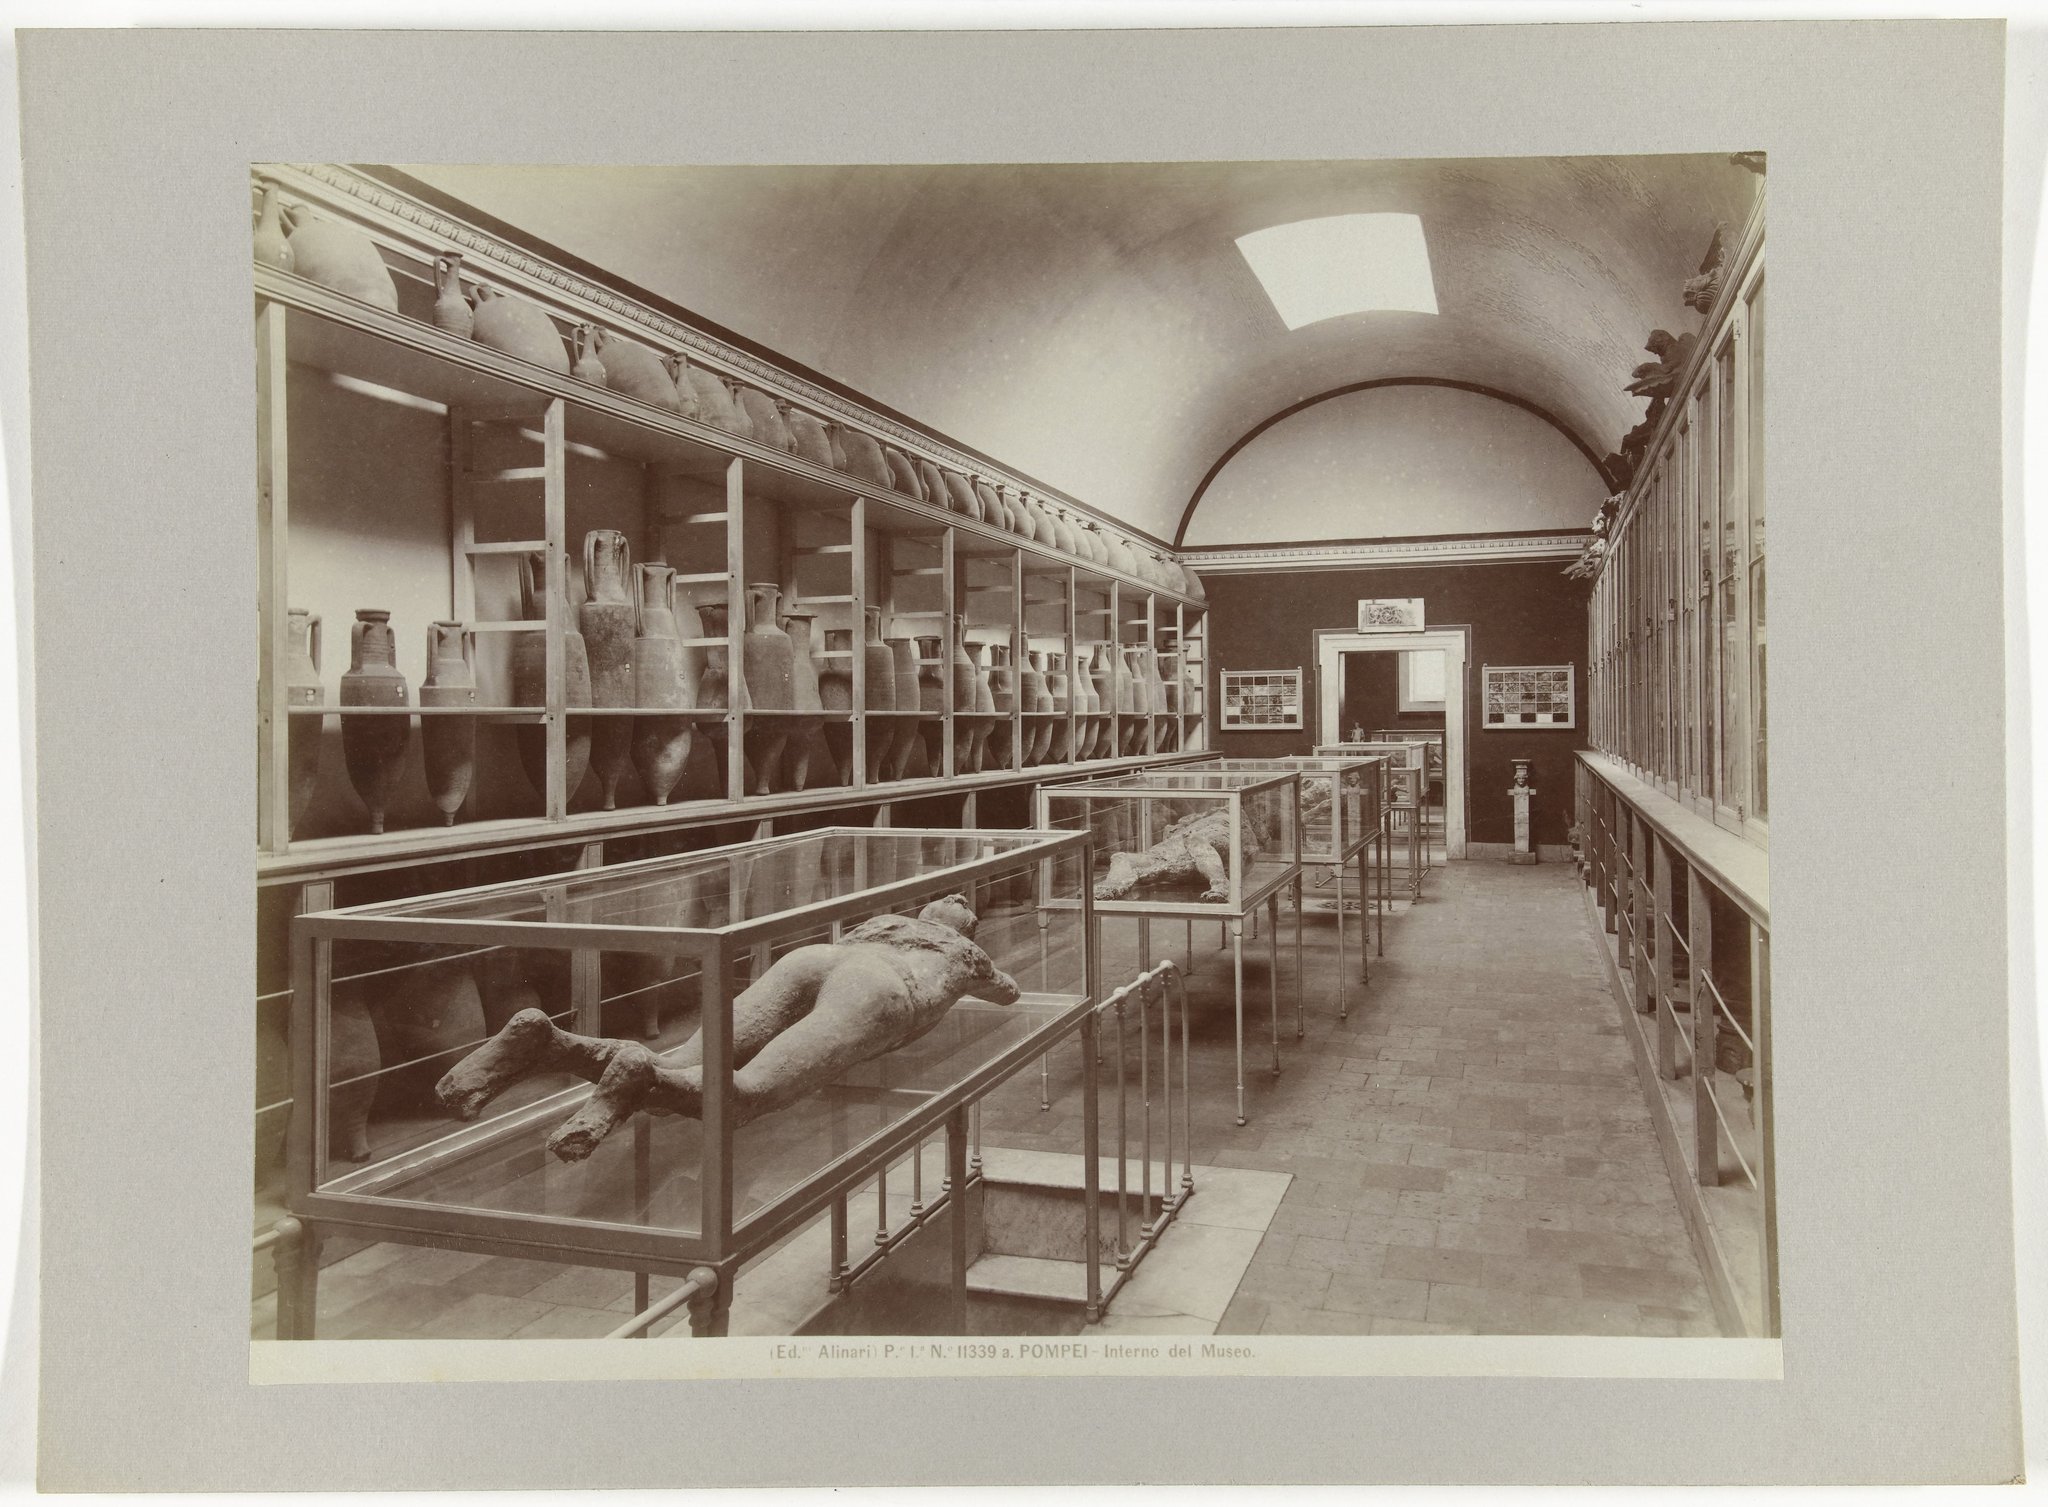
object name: photograph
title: P.e 1.a N.o 11339a. POMPEI - Interno del Museo.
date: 1880-1895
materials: cardboard, paper, photographic support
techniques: albumen print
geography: florence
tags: permanent exhibition, museum, pompeii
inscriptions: number: ‘66.’